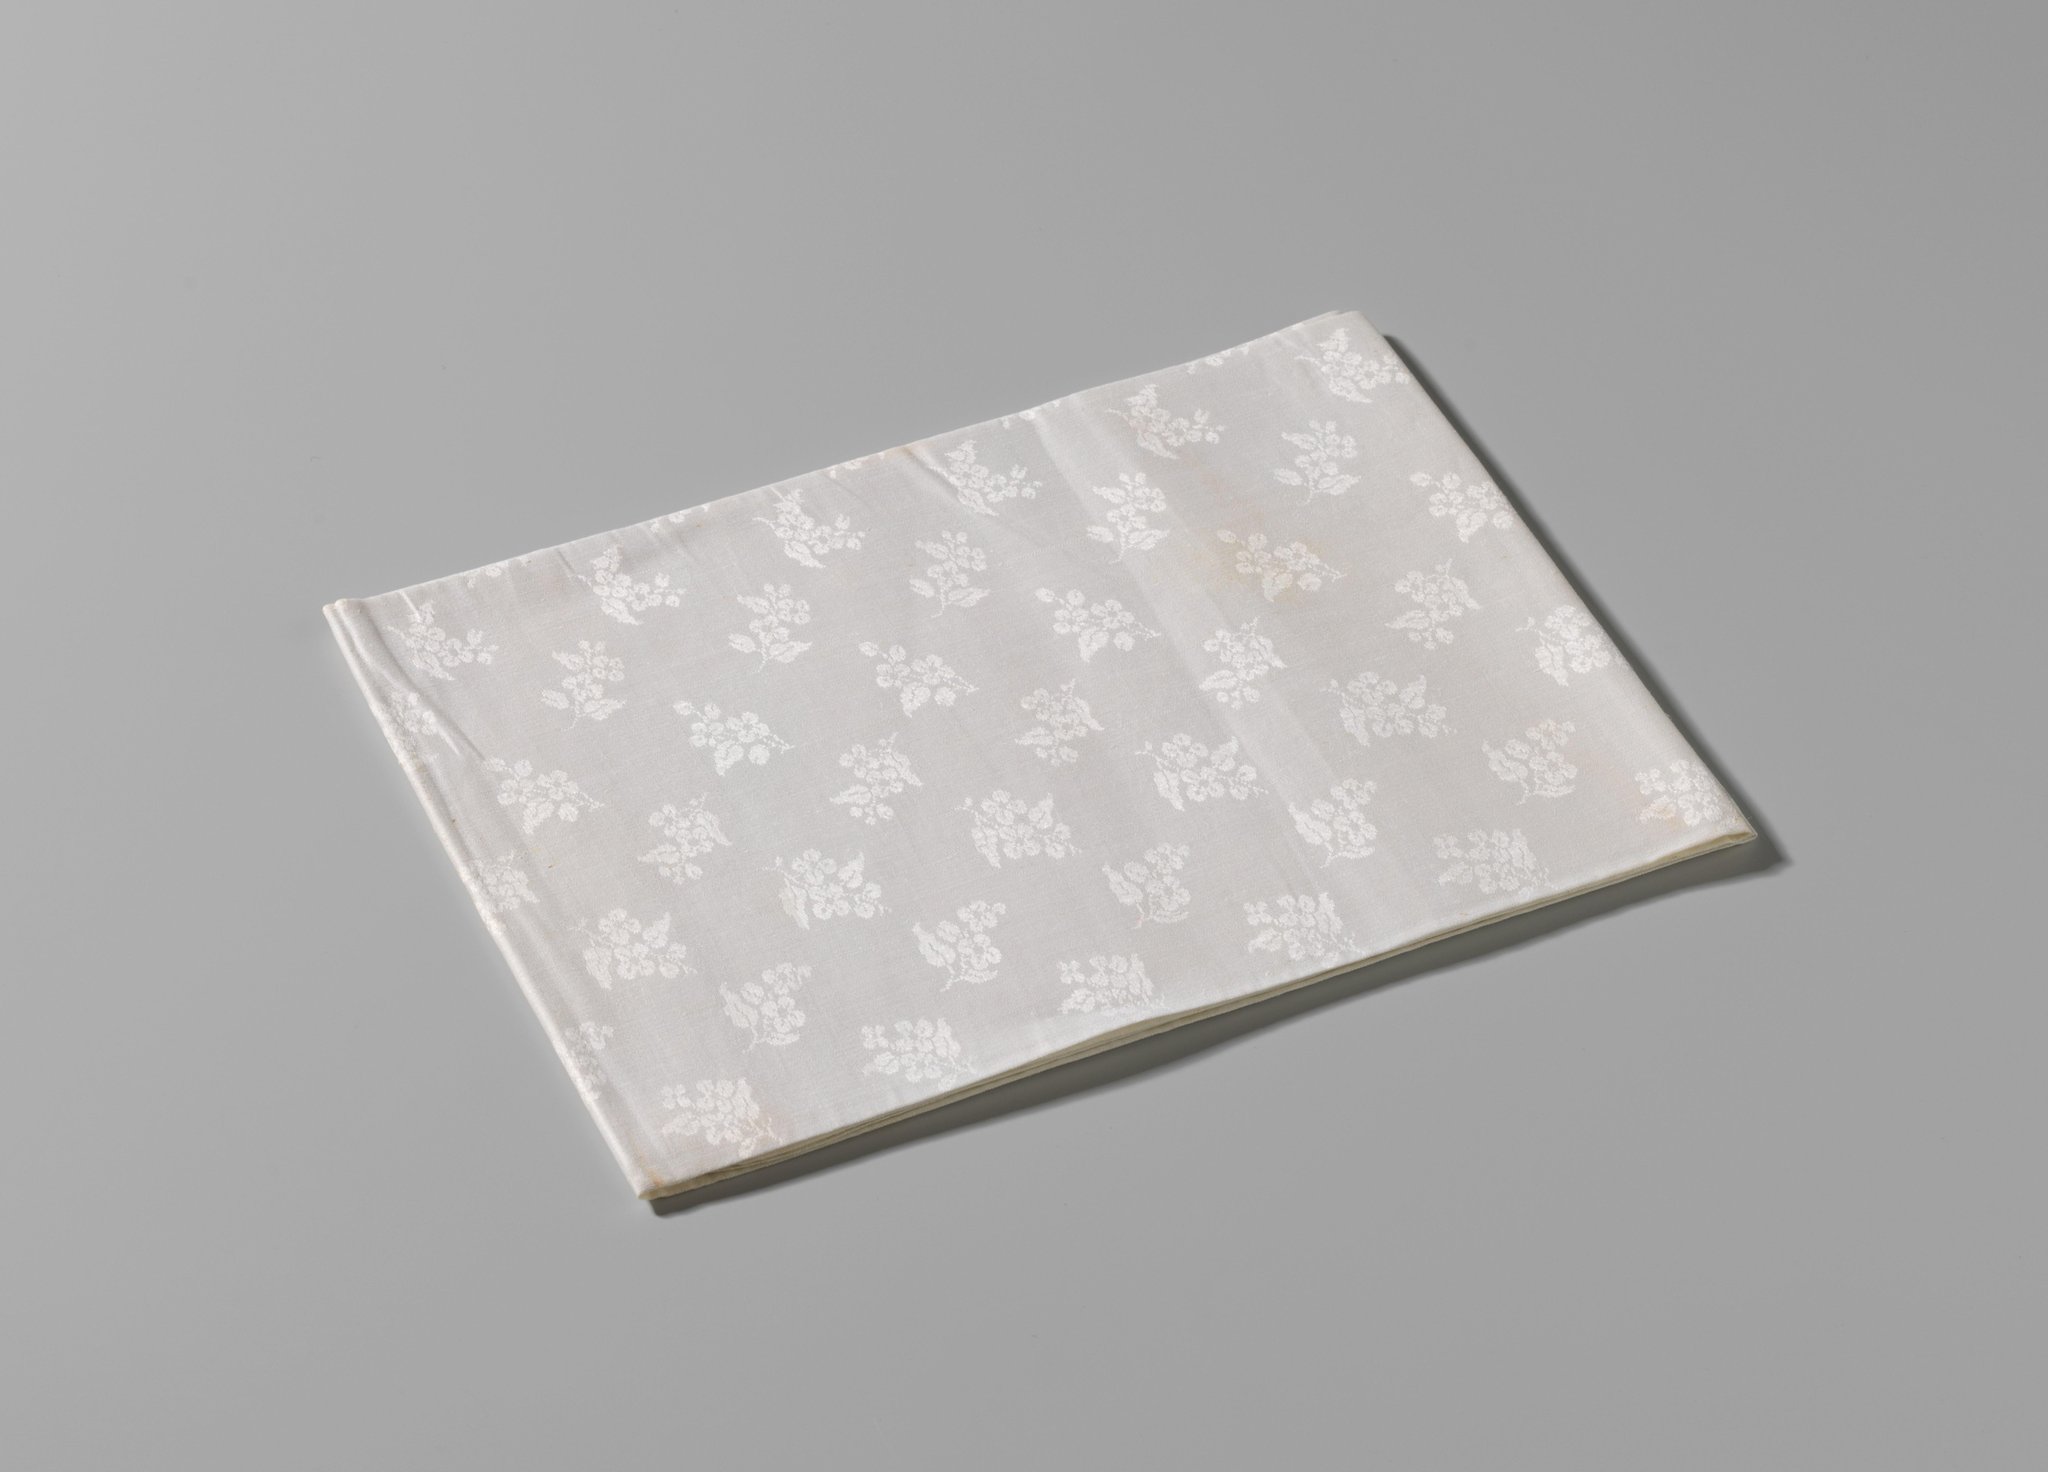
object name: napkin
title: Servet met strooibloemen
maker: Anonymous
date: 1700-1899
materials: linen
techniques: damask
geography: saxony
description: Vergelijk E. Kumsch, Leinendamastmuster des XVII. und XVIII. Jahrhunderts, Dresden 1891, Taf. 9,1.